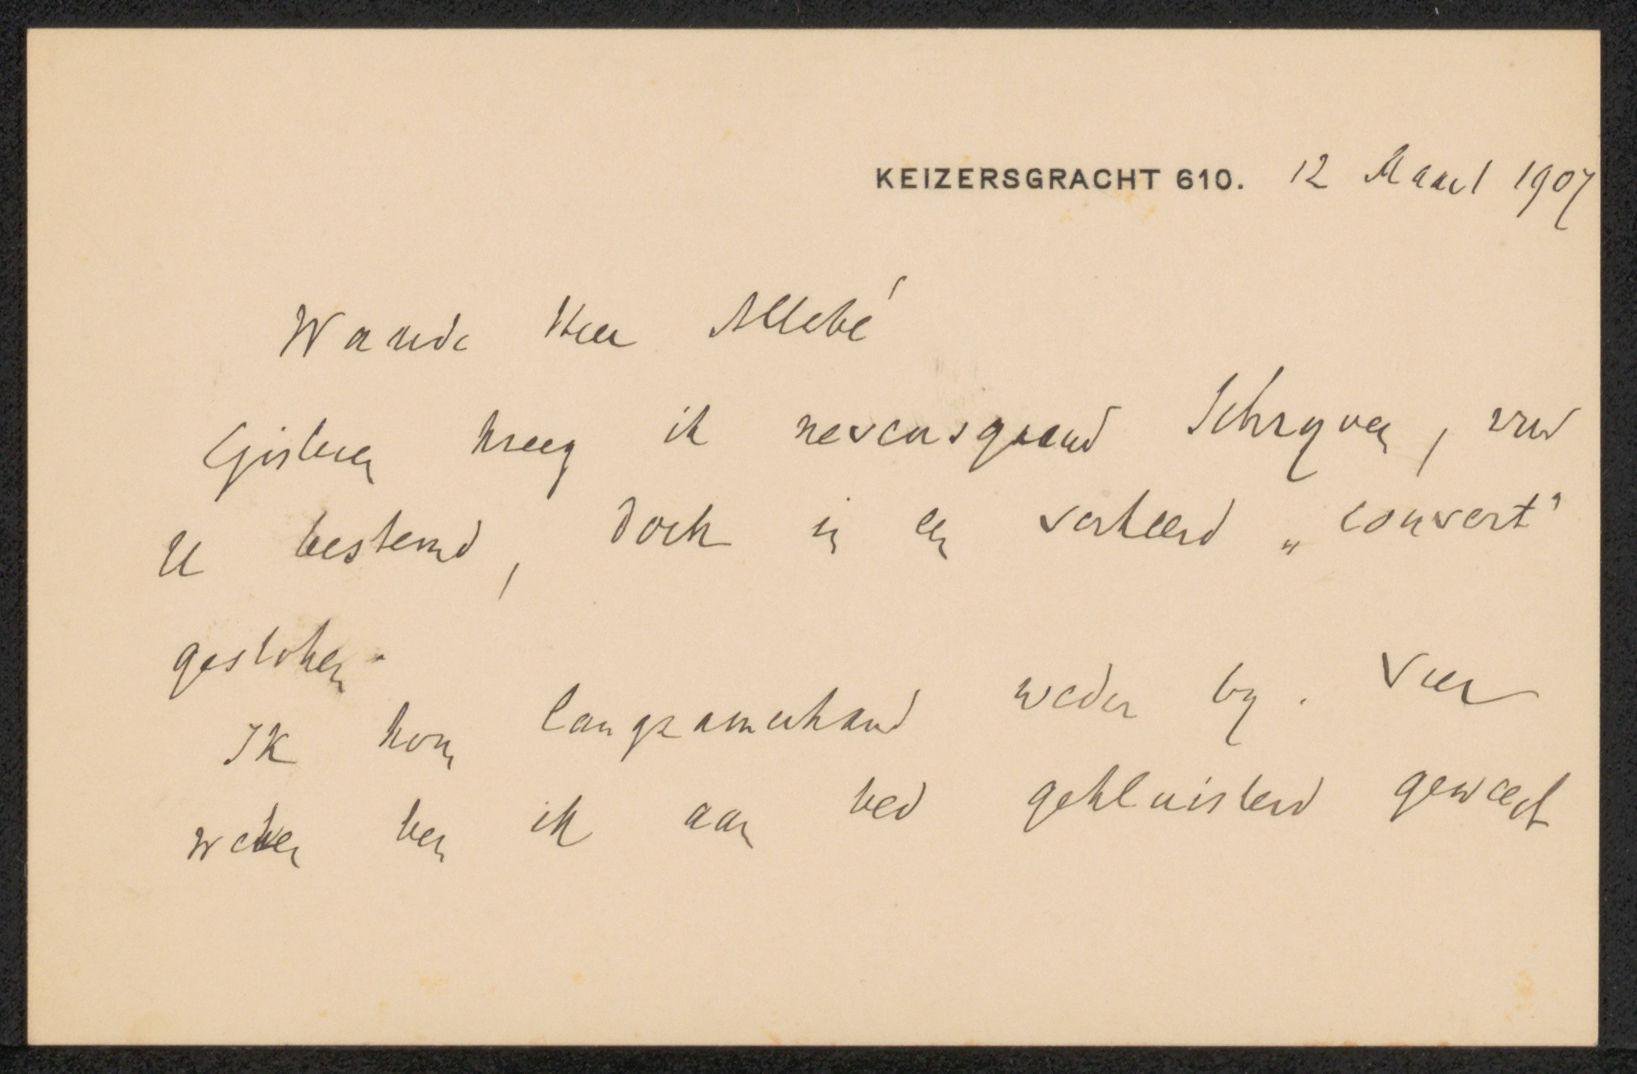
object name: letter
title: Brief aan August Allebé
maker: hendrick peter godfried quack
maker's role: econoom, geschiedschrijver, hoogleraar, jurist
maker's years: 1834-1917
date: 1907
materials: cardboard, ink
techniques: pen, printing, writing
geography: amsterdam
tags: print maker, draughtsman, august allebé, diseases